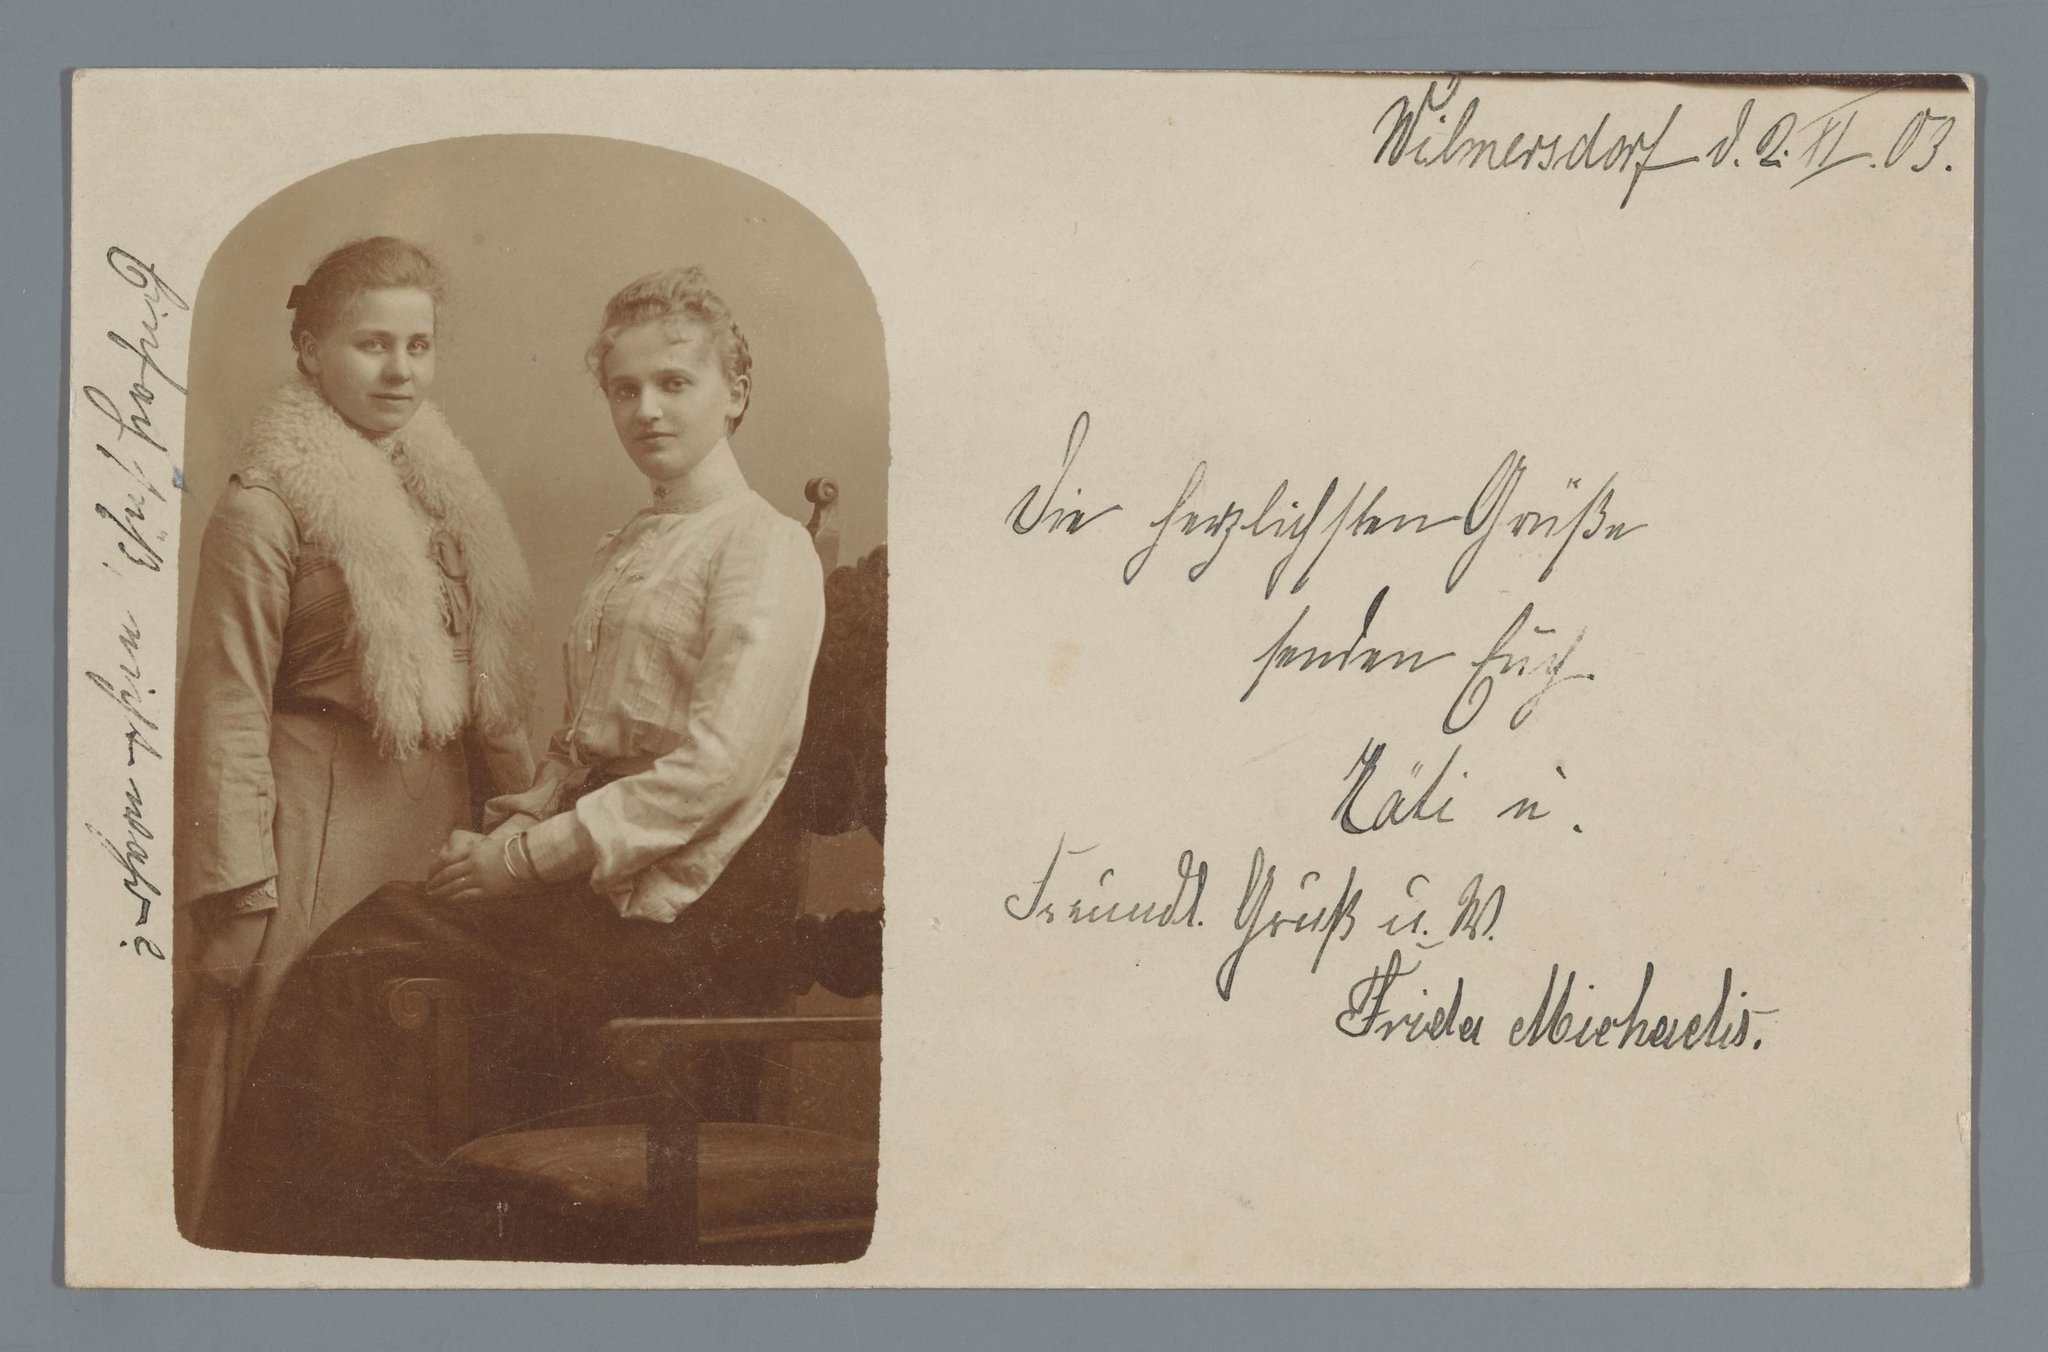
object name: ansichtkaart, prentbriefkaart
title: Portret van twee onbekende vrouwen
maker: Anonymous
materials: photographic support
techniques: gelatin silver print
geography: germany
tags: adult woman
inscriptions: inscription: ‘Wilmersdorf (...) Frida Michaelis’, inscription: ‘[...] O. Brand (...) Mühlenstr. No 11. III’